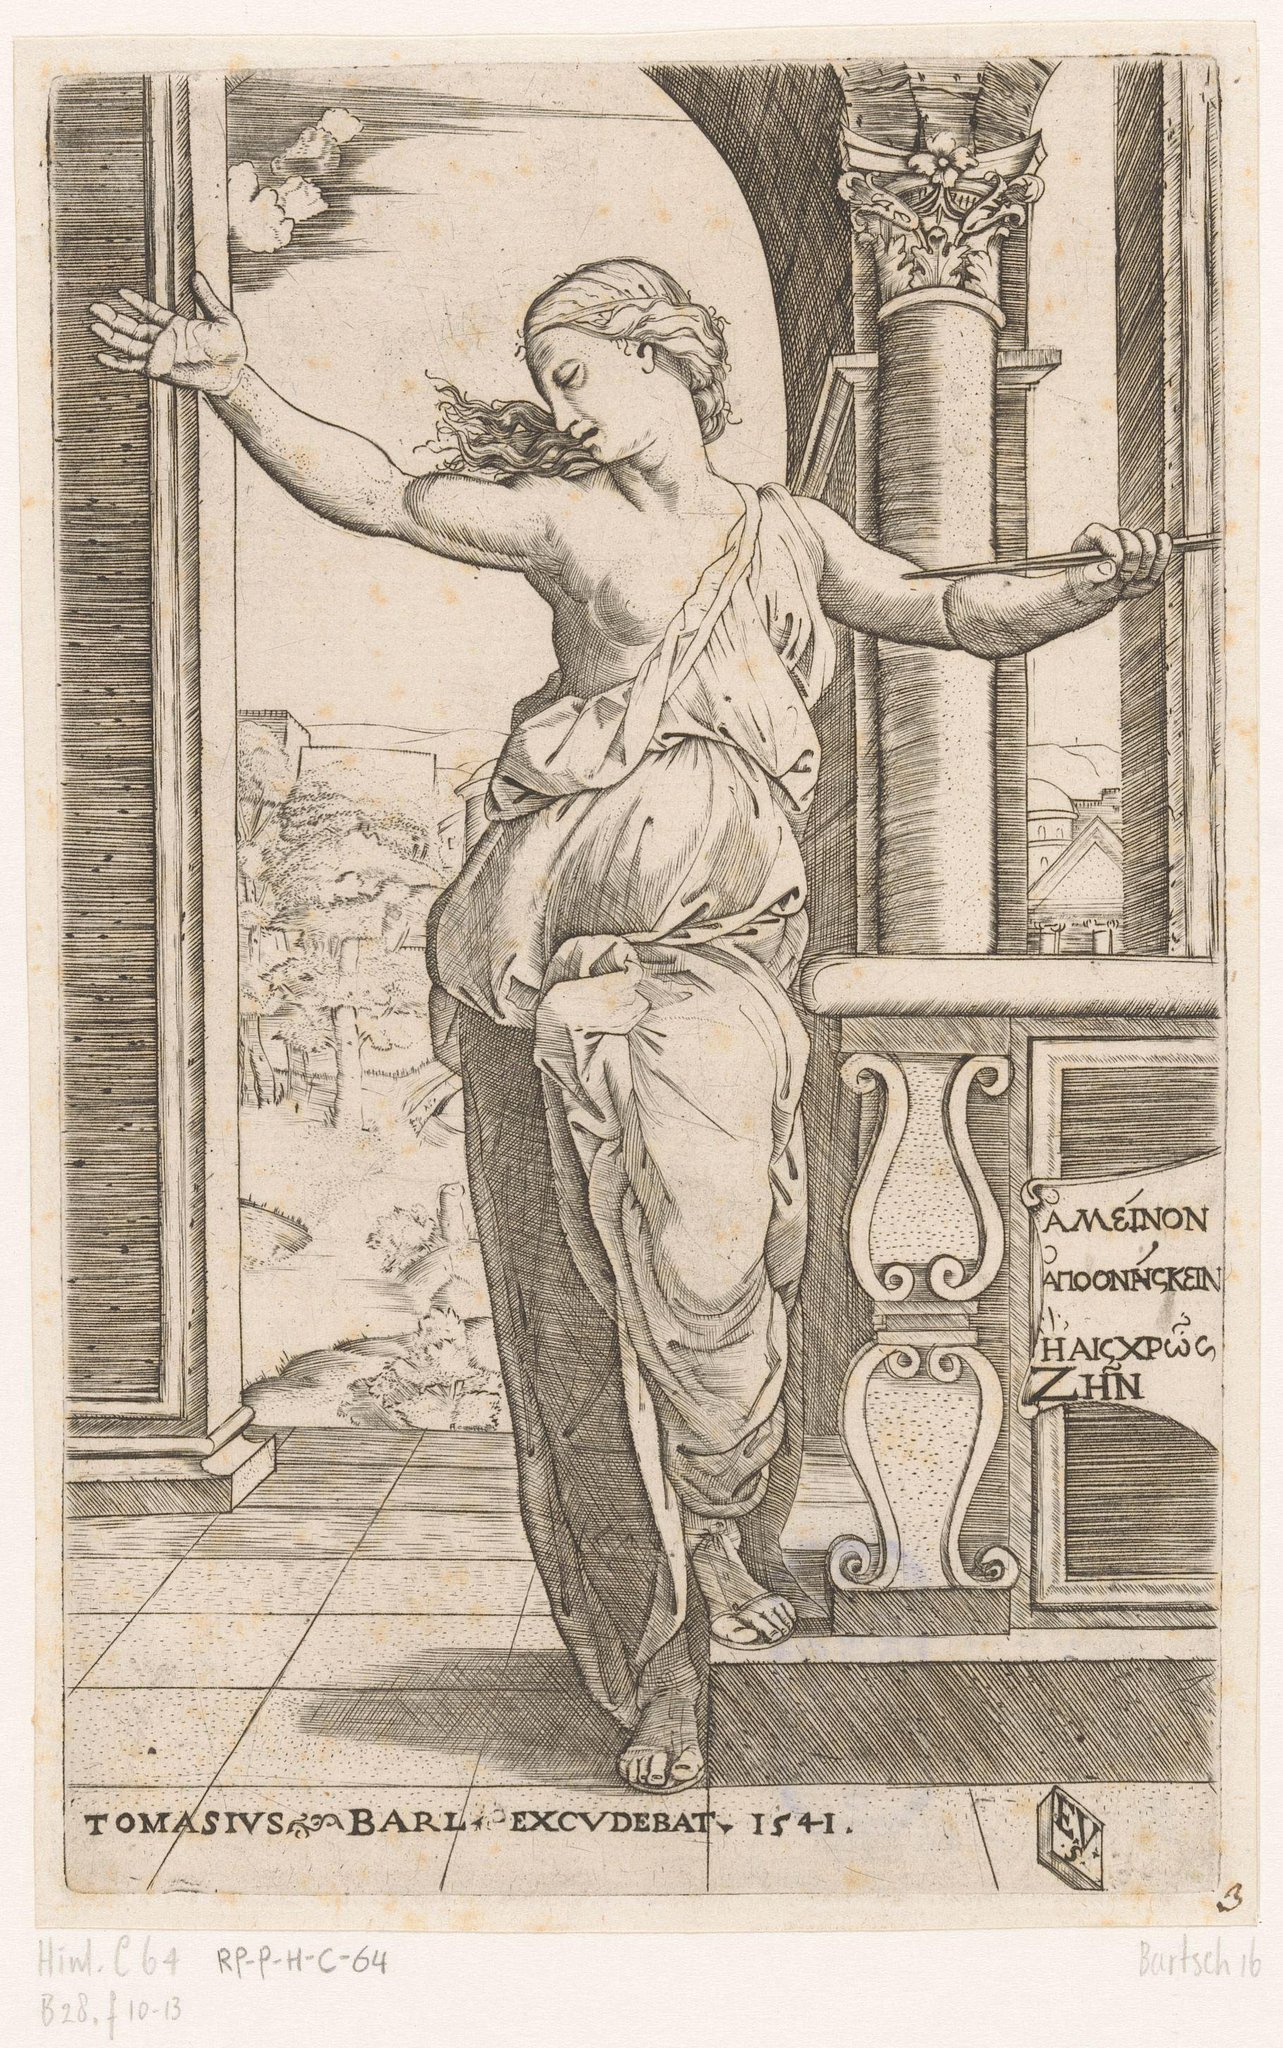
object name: print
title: Zelfmoord van Lucretia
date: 1541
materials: paper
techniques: engraving, etching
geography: italy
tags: city-view, and landscape with man-made constructions, death of lucretia: she commits suicide by stabbing herself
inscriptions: collector's mark: ‘Hinloopen’, number: ‘3’, collector's mark: Lugt 11, collector's mark: Lugt 10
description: Lucretia staat op het punt zich te doorsteken met een dolk. Op de achtergrond een doorkijk naar een landschap. Rechts een tekst in het Grieks.